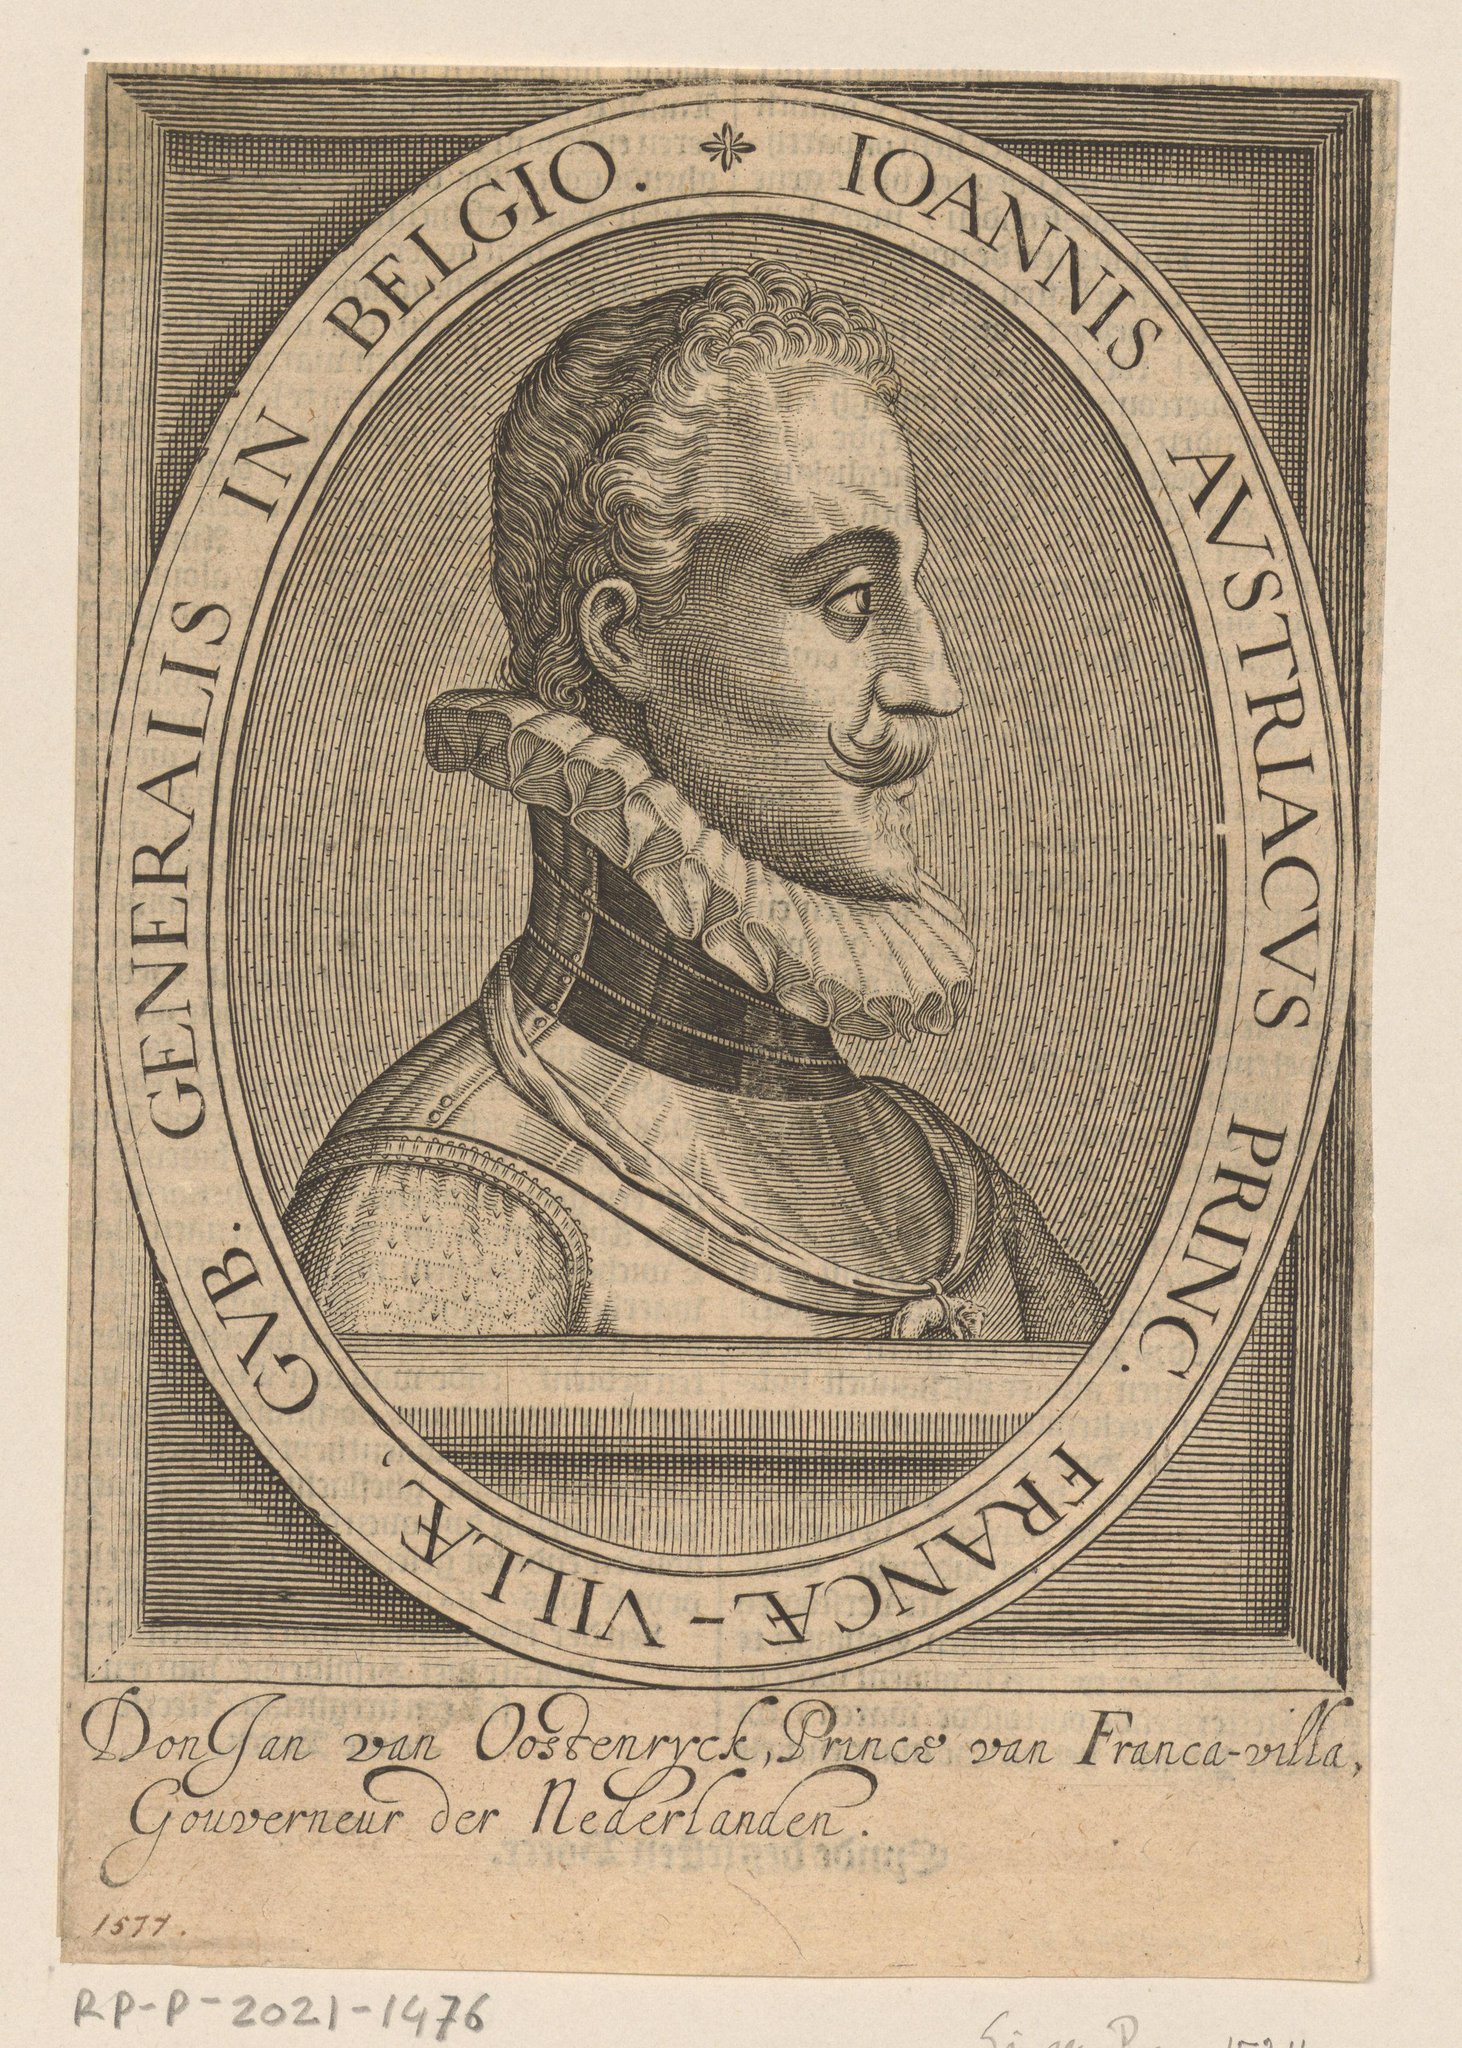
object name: print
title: Portret van Don Juan van Oostenrijk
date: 1614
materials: paper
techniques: engraving, letterpress printing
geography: the hague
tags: don juan van oostenrijk, historical persons, knighthood order of the golden fleece, ruler, sovereign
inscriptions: inscription: ‘1577’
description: Prent uit: Meteren, Emanuel van. Historie der Nederlandscher ende haerder na-buren oorlogen ende geschiedenissen (...). Den Haag: Hillebrant Iacobsz. van Wouw I, 1614.